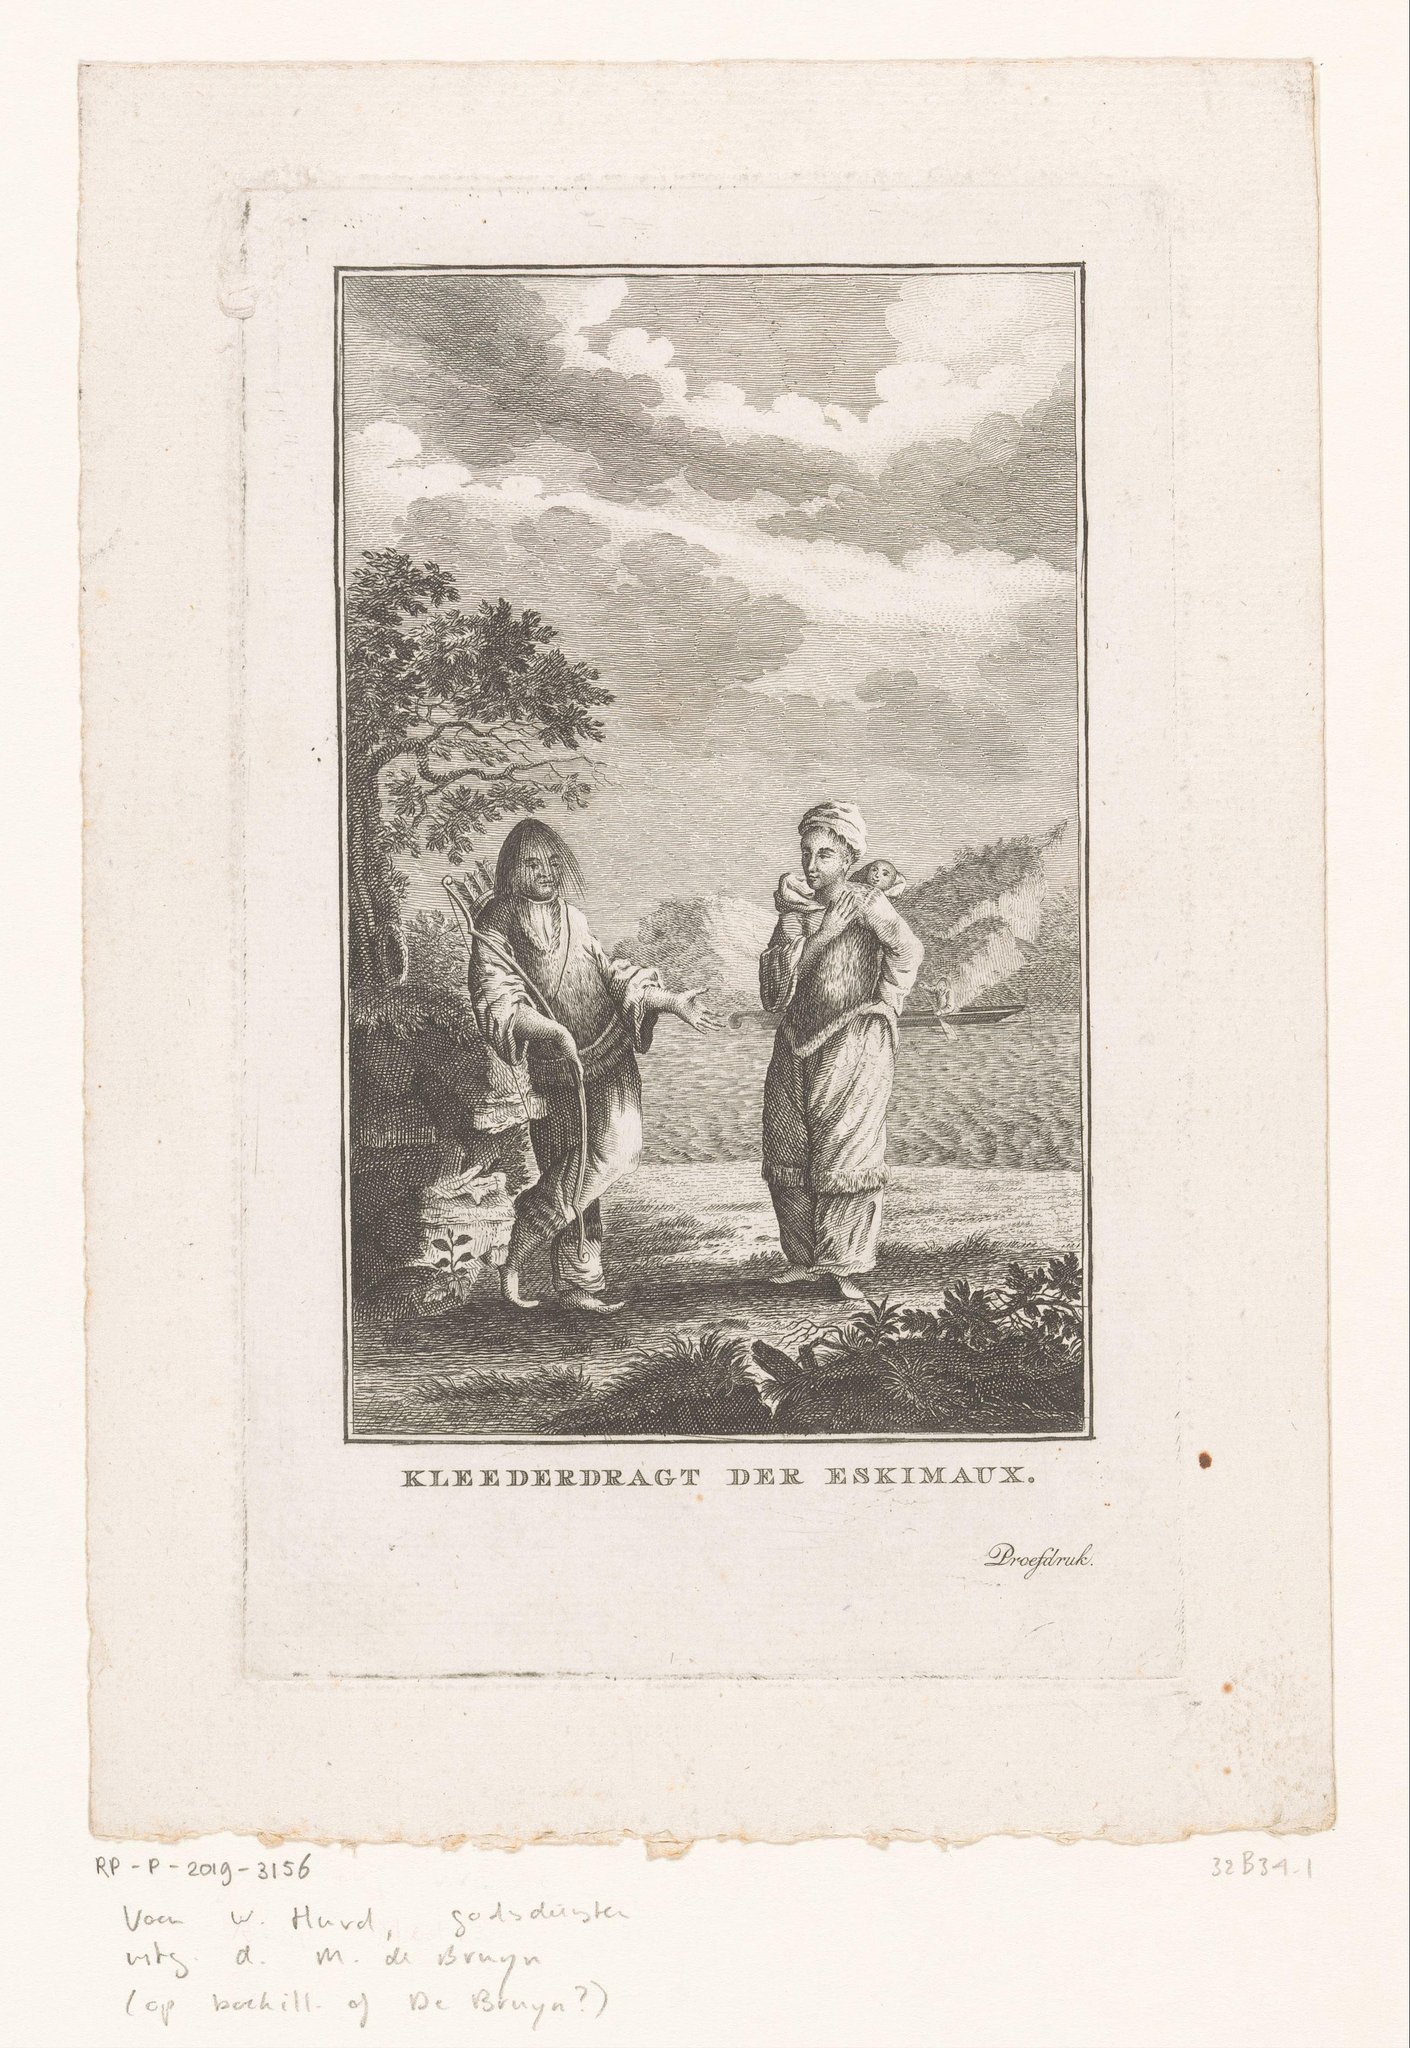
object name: print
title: Inuit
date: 1781-1791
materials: paper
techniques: engraving, etching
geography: netherlands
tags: indigenous peoples of the arctic regions: inuit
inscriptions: collector's mark: Lugt 2228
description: Proefdruk van een prent uit: Hurd, William. Geschiedenis van alle godsdiensten (...). Amsterdam: Martinus de Bruyn, 1781-1791, dl. 7, p. 256 (verso).